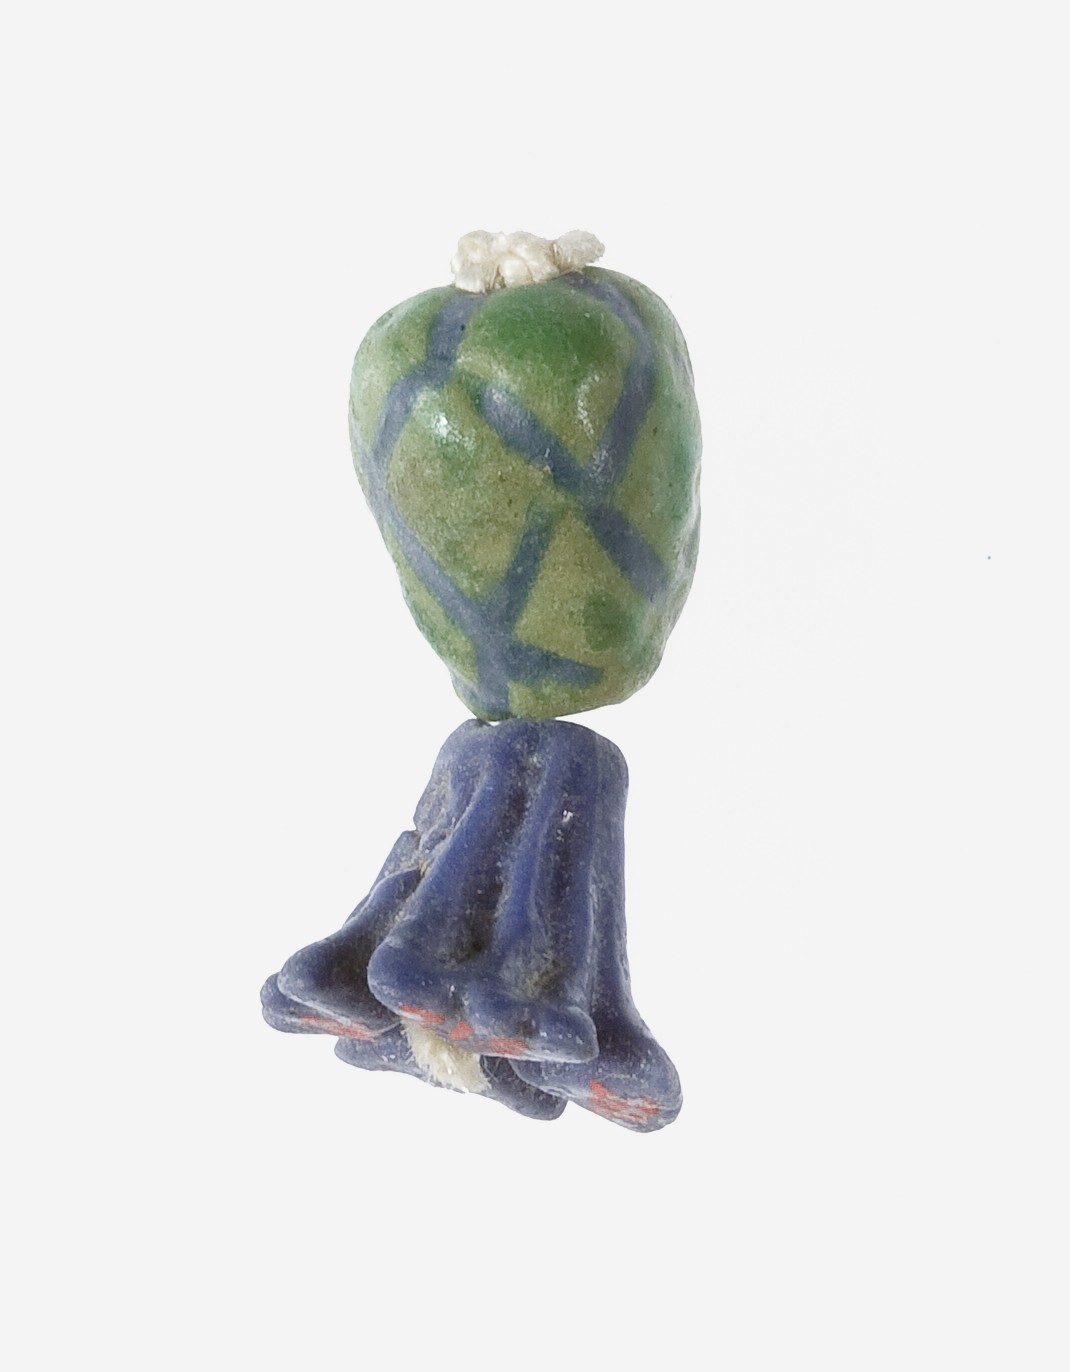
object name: pendant, cornflower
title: Cornflower Pendant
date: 1390-1352 BCE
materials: faience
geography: egypt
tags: flowers